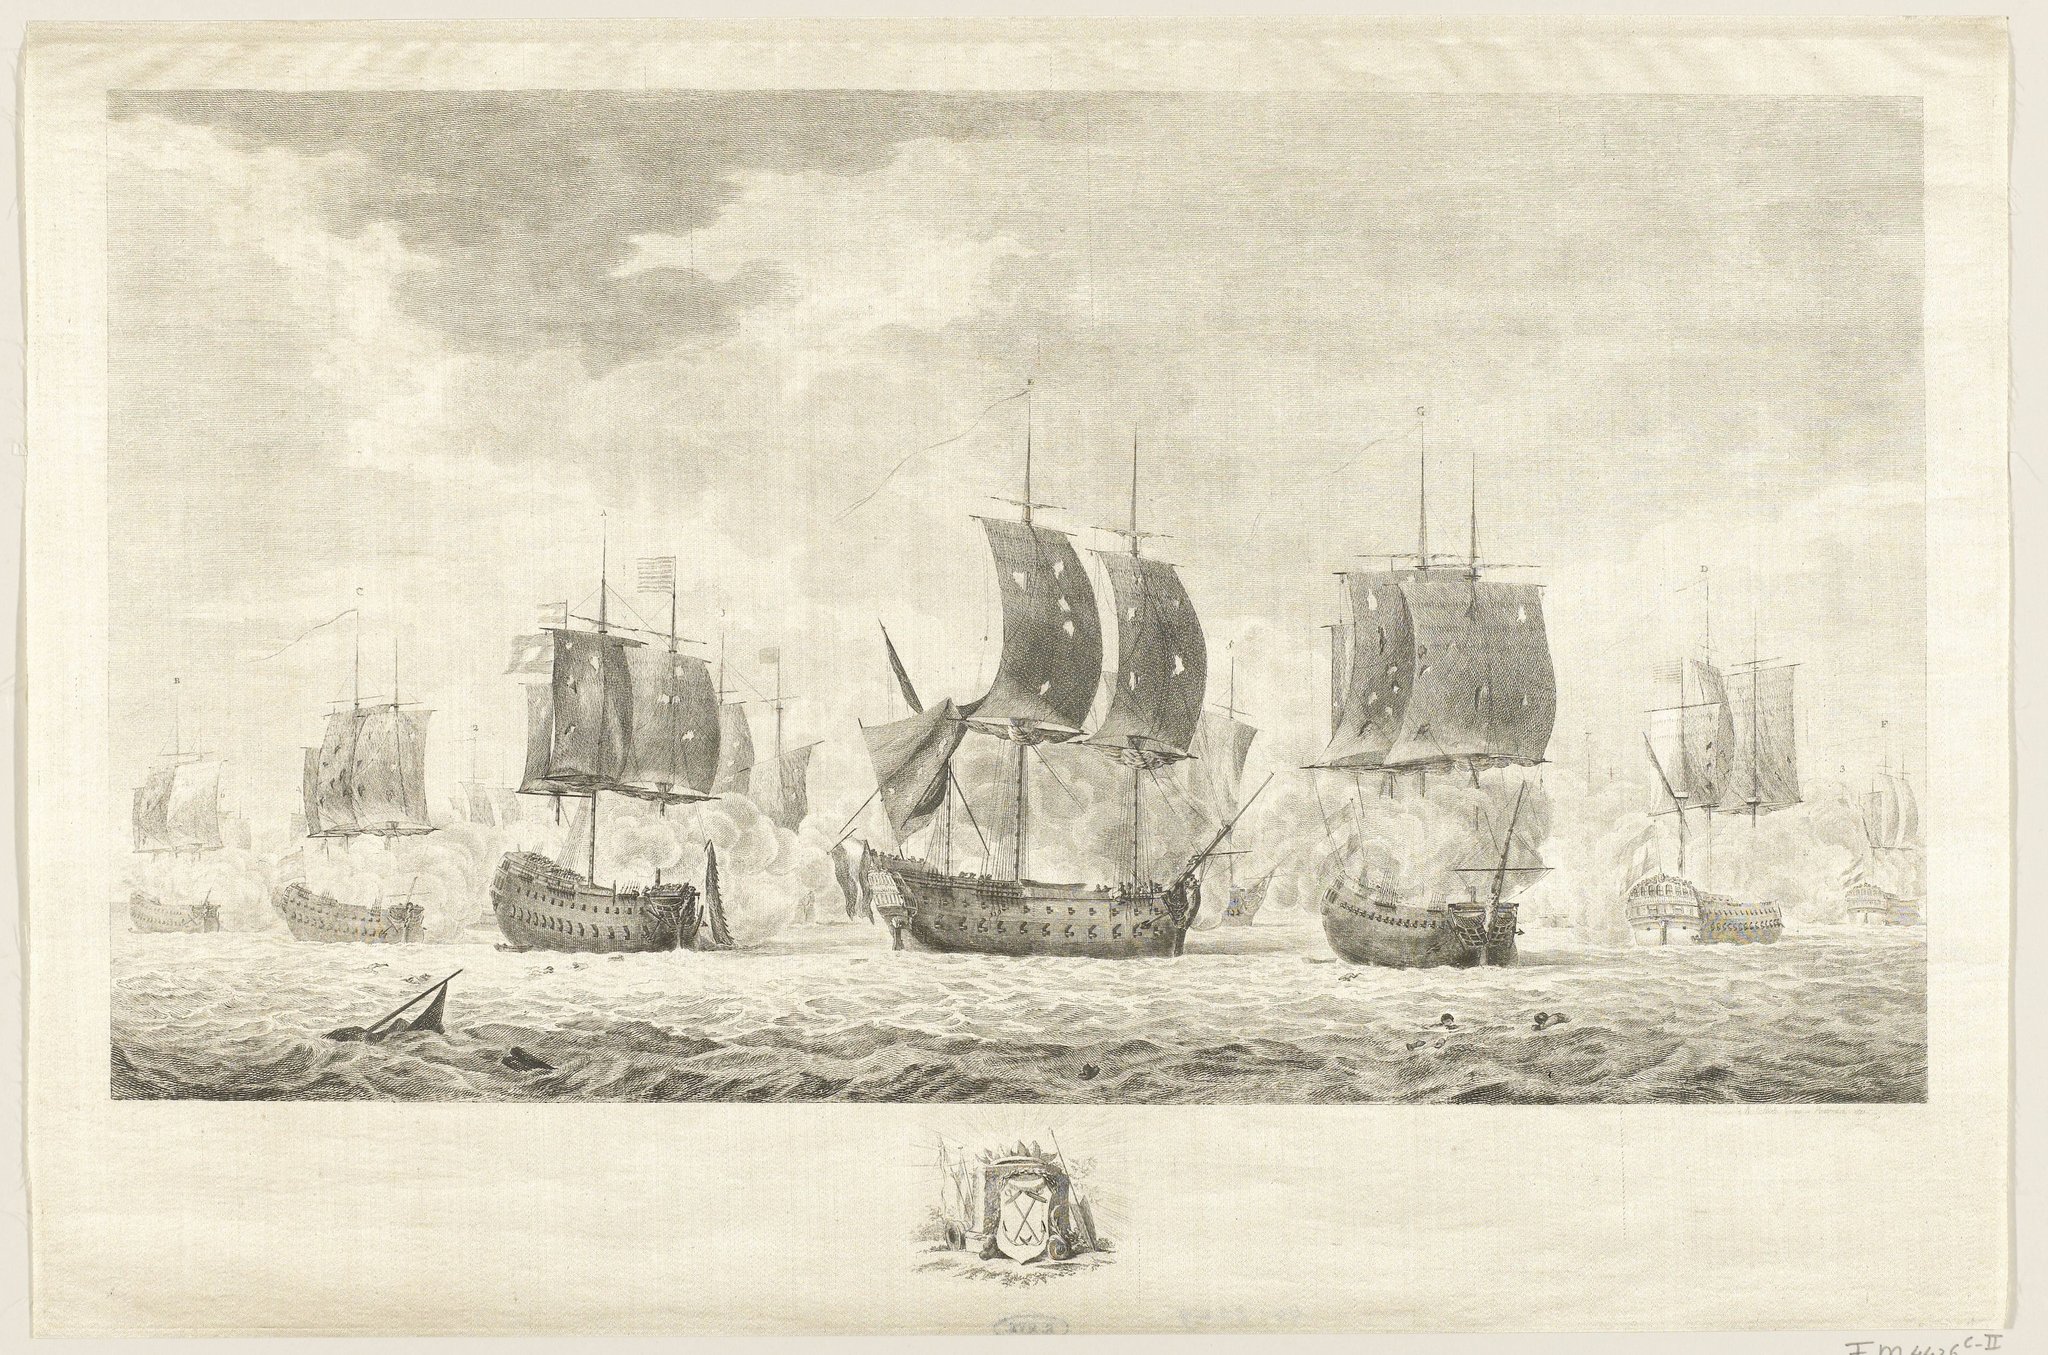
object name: print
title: Zeeslag bij Doggersbank, 1781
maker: mathias de sallieth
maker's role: print maker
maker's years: 1749-1791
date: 1781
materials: textile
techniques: engraving, etching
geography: rotterdam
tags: the hague, johan arnold zoutman, hyde parker, battle (+ naval force)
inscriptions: collector's mark: Lugt 2228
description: De Nederlandse en Engelse tijdens de zeeslag bij Doggersbank op 5 augustus 1781 tussen de Nederlandse vloot onder schout-bij-nacht Johan Zoutman en de Engelse vloot onder vice-admiraal Hyde Parker. In de marge alleen een trofee. Onderdeel van een serie van drie platen van de Zeeslag op de Doggersbank, in proefdruk vóór de letter op satijn.